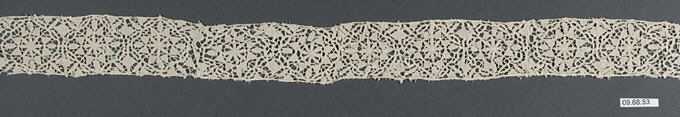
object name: border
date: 1600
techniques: lace